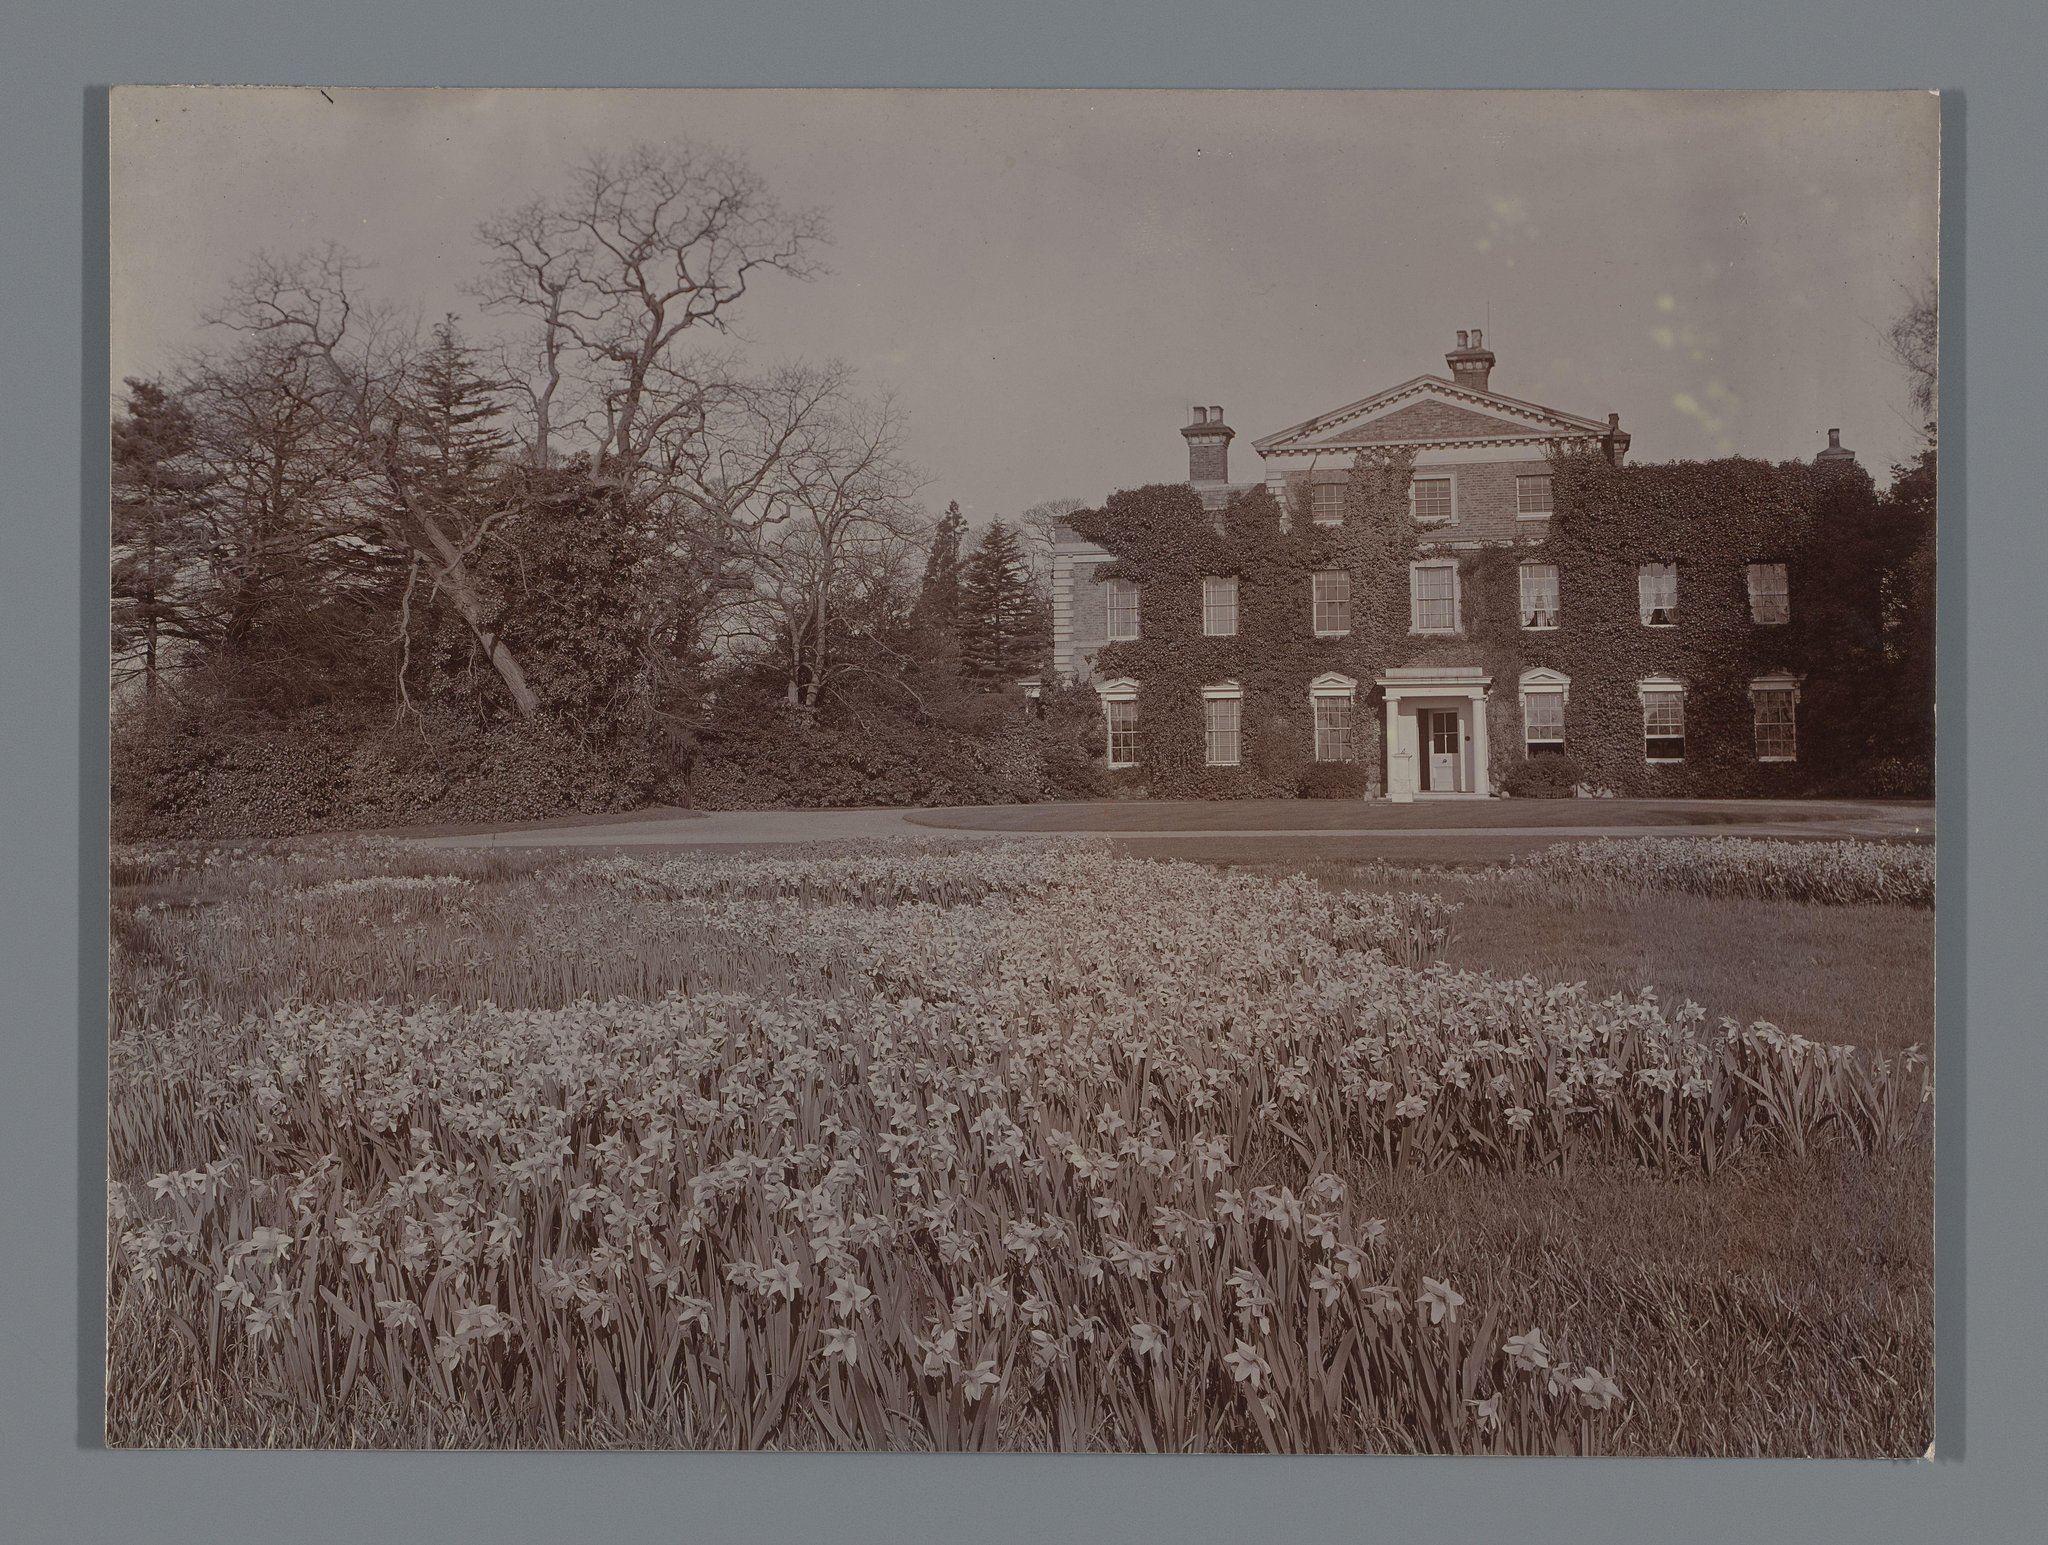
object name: photograph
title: Landhuis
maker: Anonymous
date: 1910-1920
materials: paper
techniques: gelatin silver print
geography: united kingdom